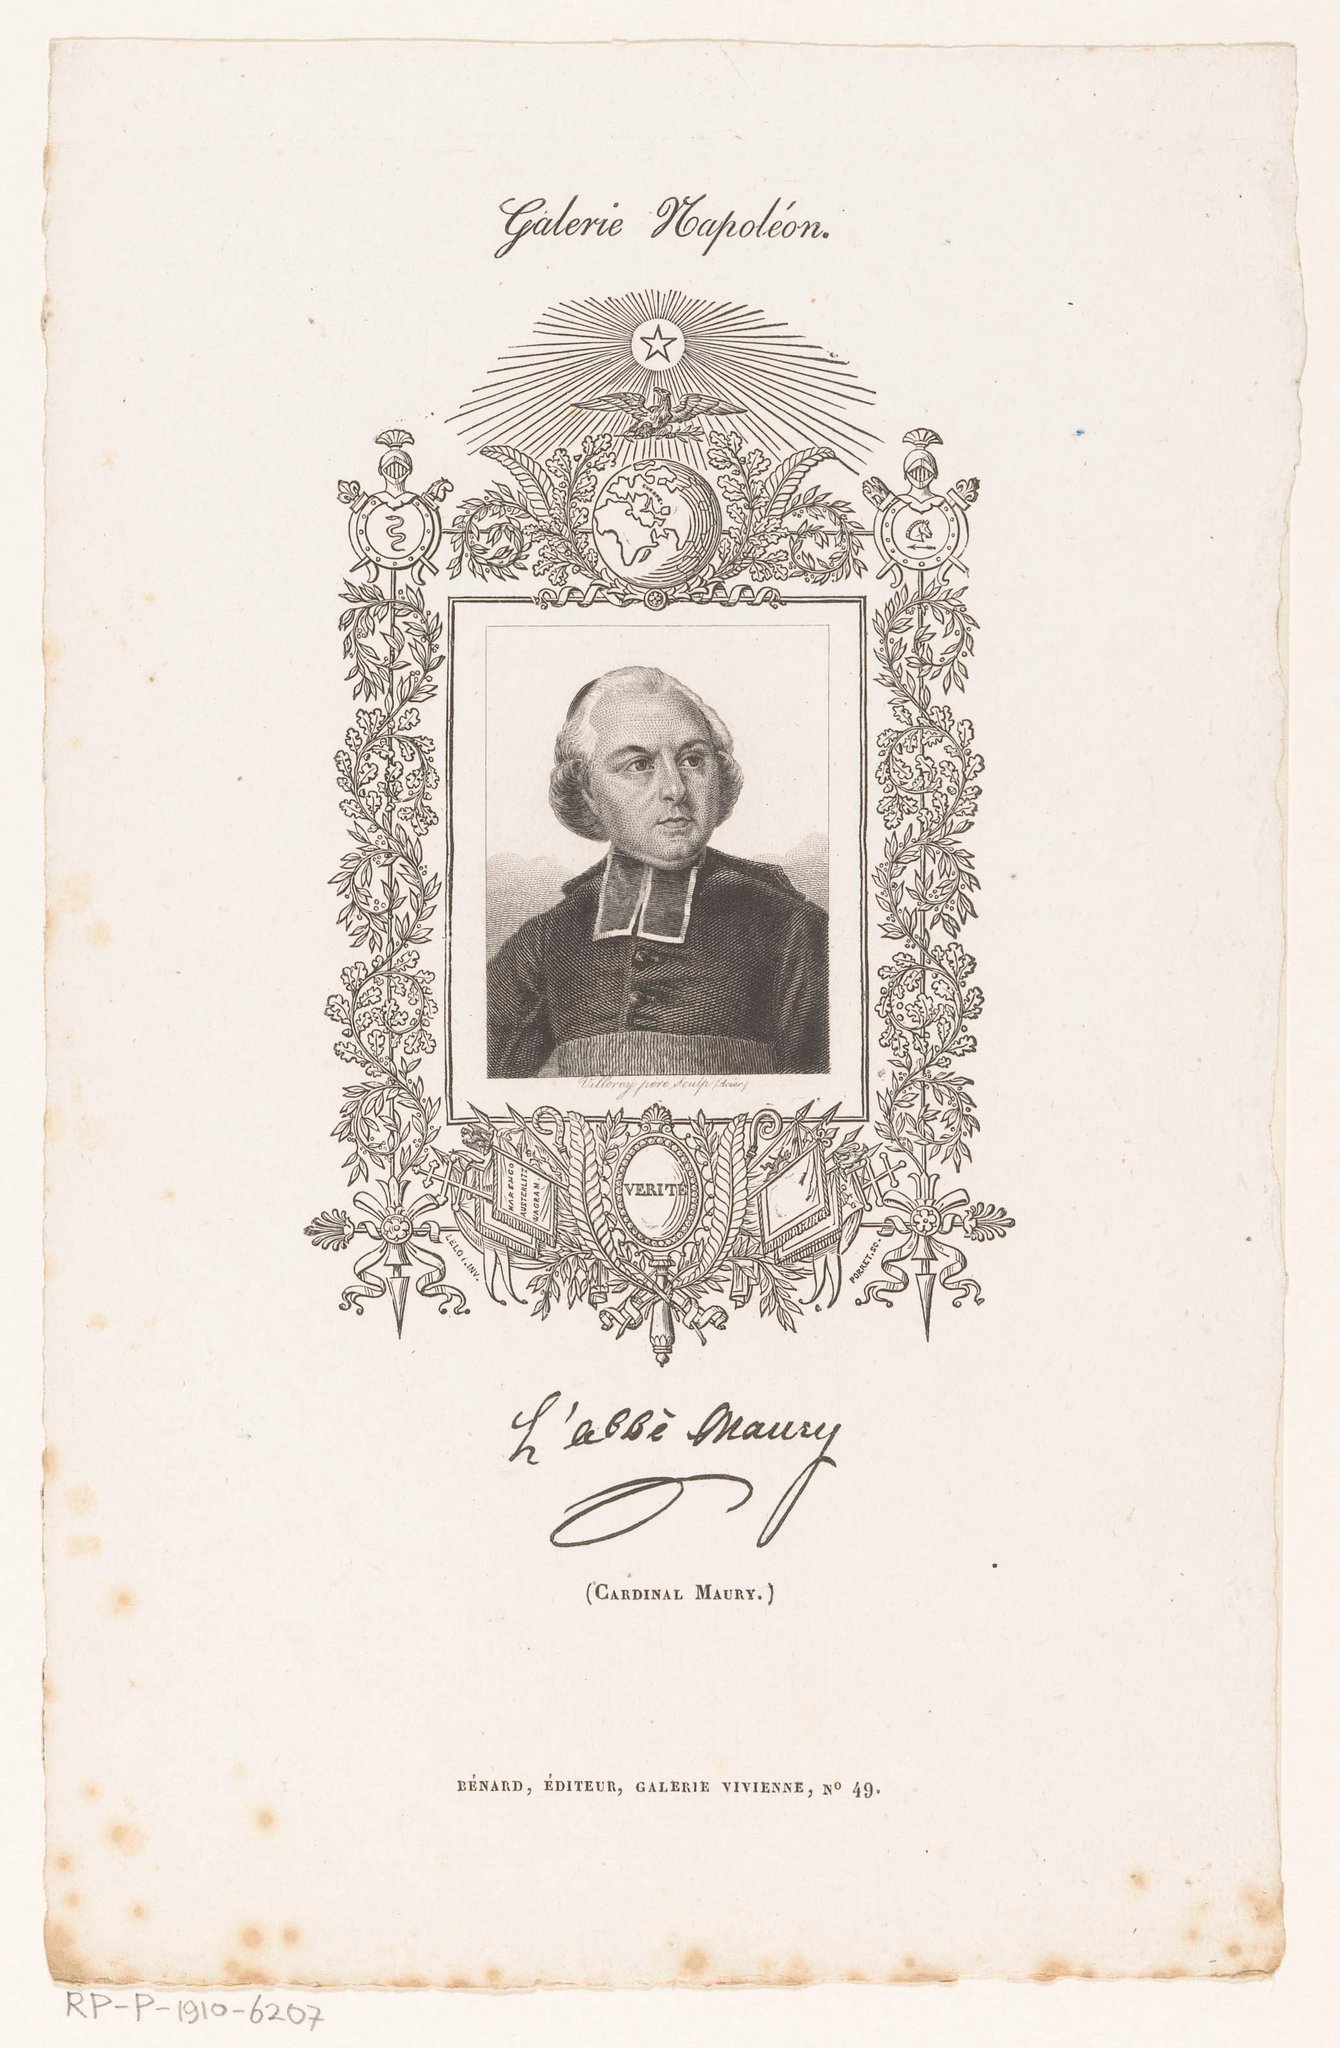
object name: print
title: Portret van kardinaal Jean Sifrein Maury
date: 1826-1828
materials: paper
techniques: etching, engraving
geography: paris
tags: cardinal, historical persons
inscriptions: collector's mark: Lugt 2228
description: Buste van kardinaal Jean Sifrein Maury in een sierlijst met planten, wapens en vlaggen.